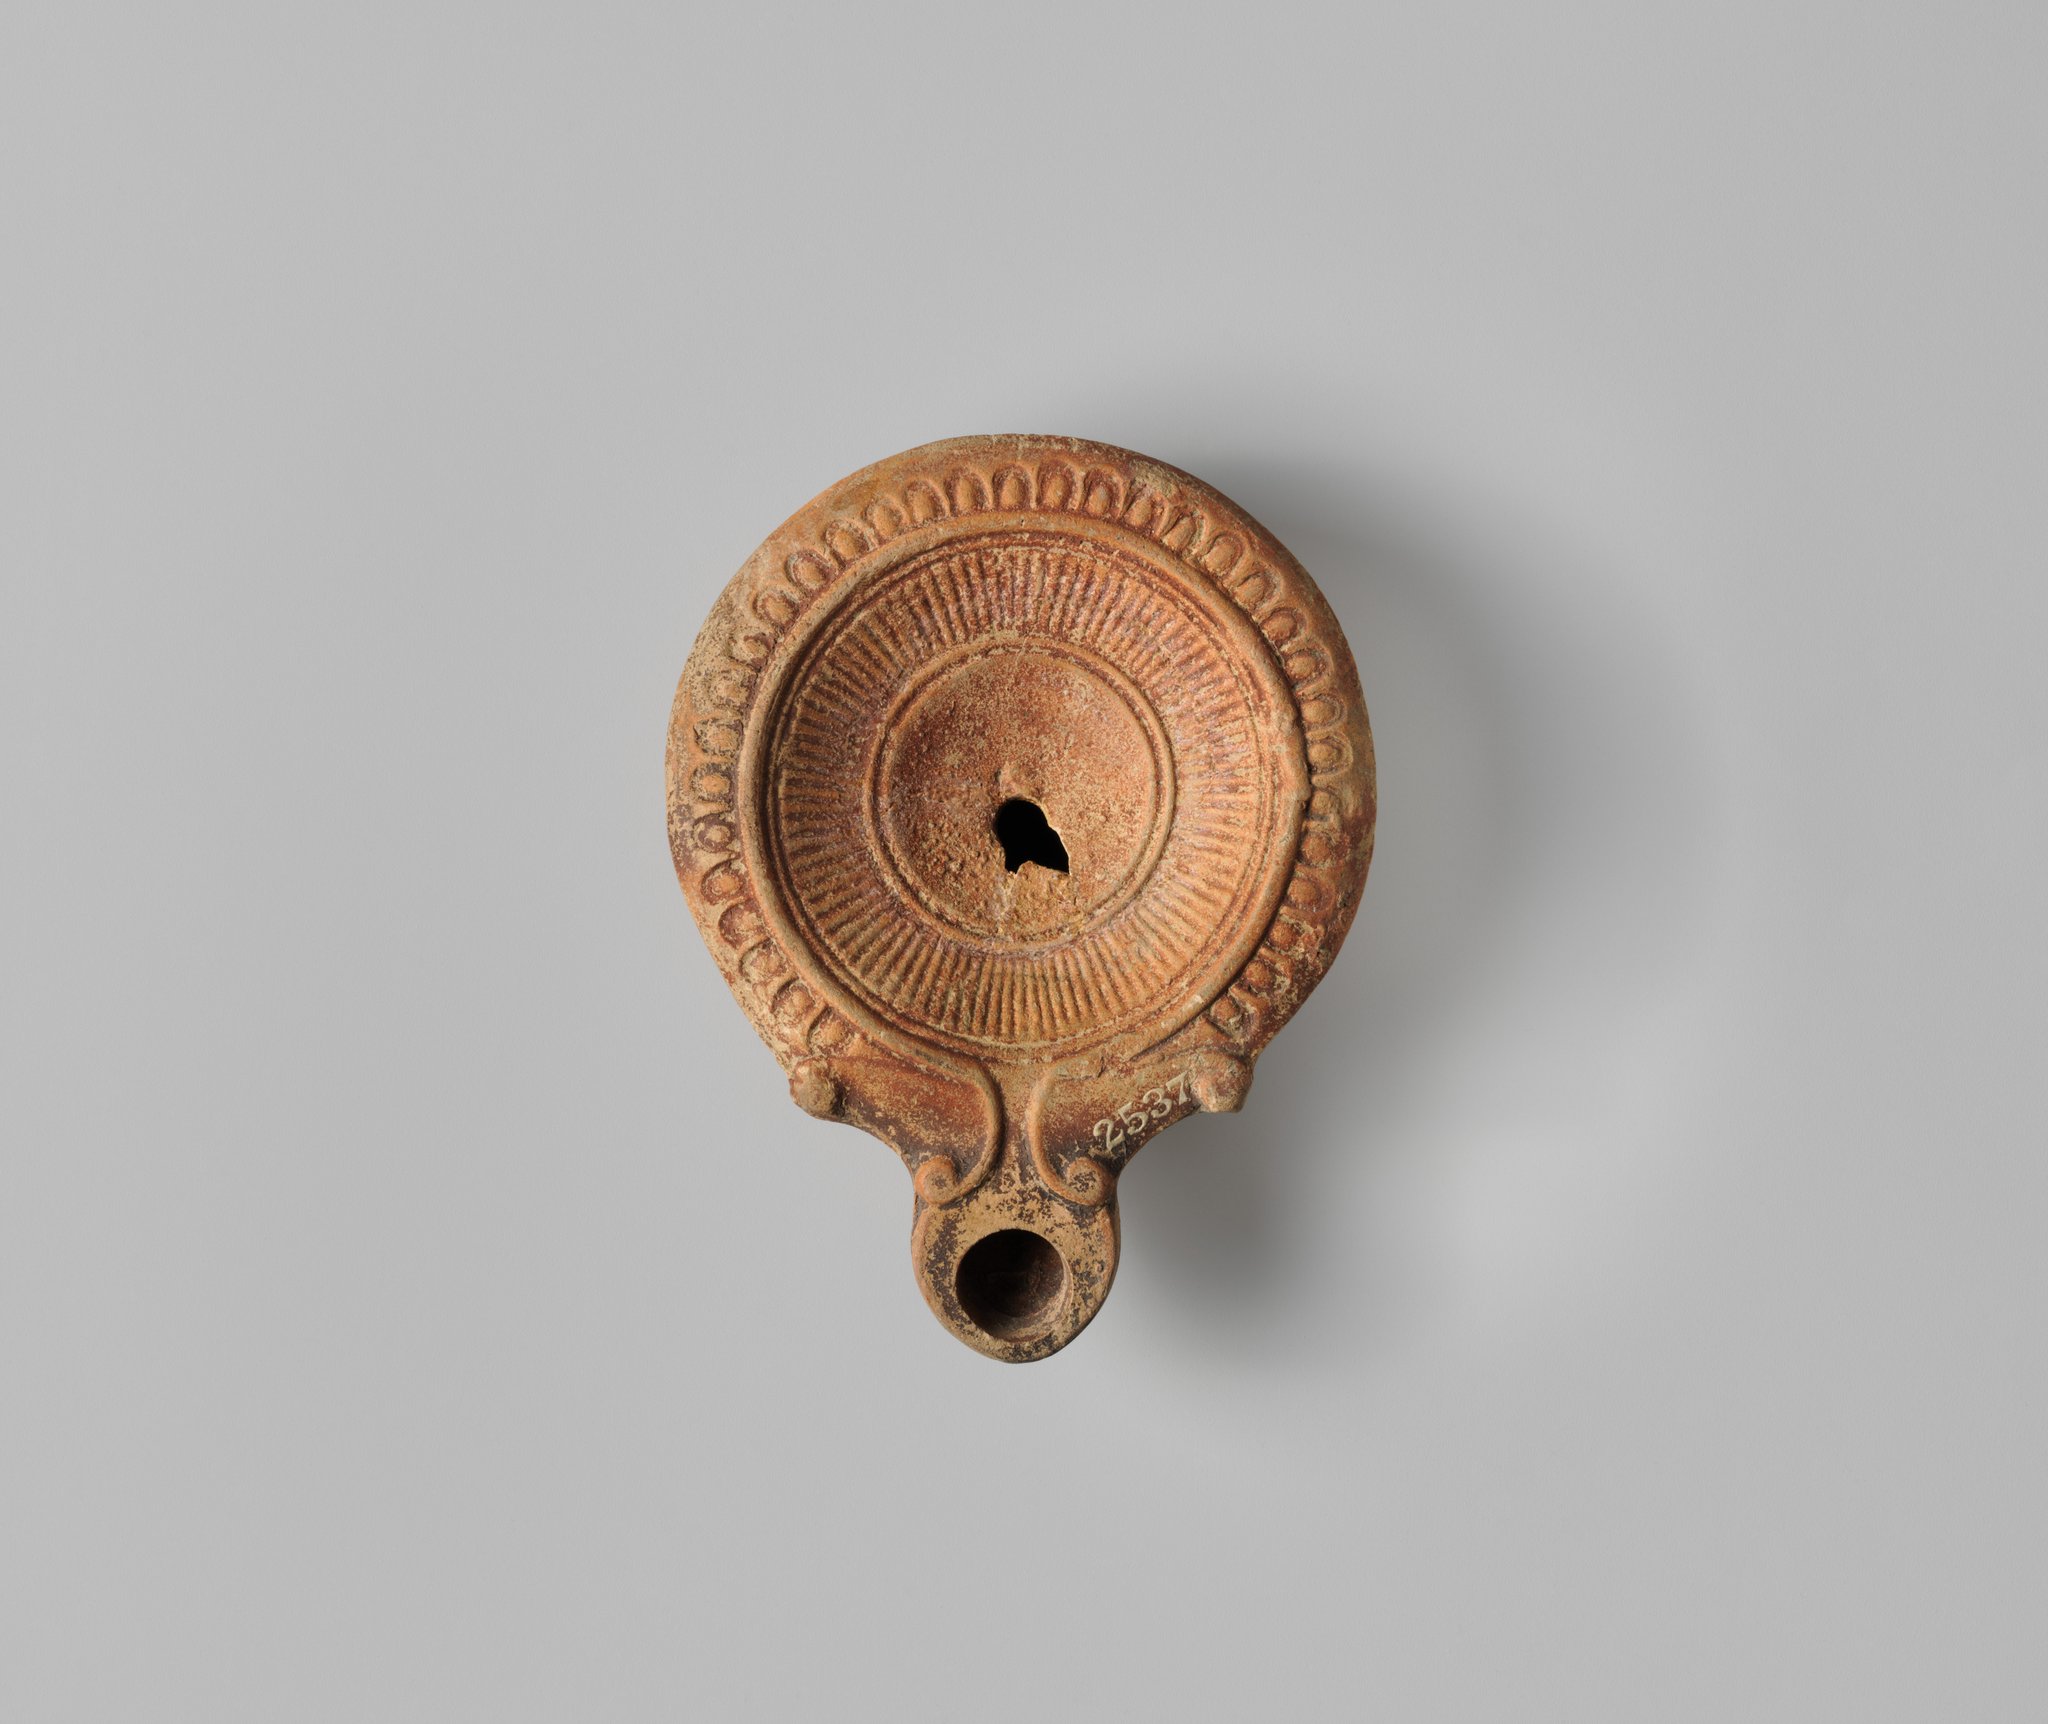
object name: lamp, concave top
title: Terracotta oil lamp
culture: roman, cypriot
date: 100 BCE-100 CE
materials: terracotta